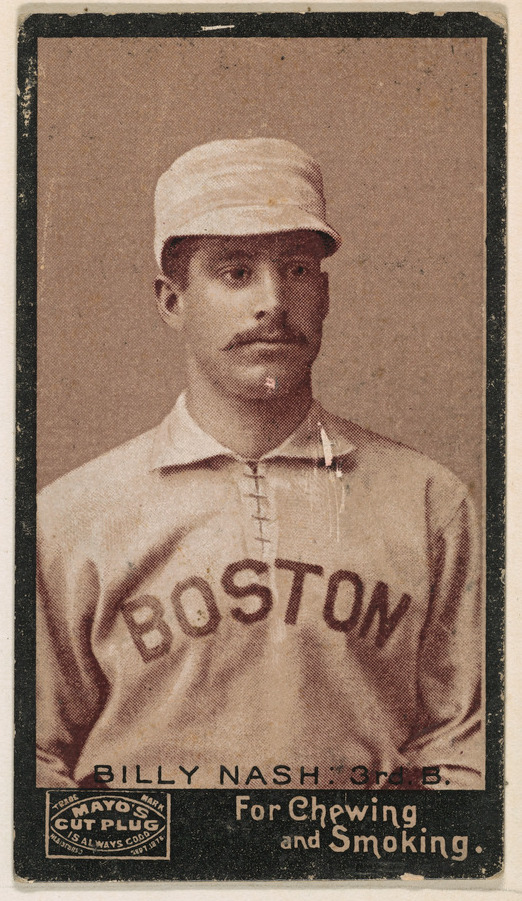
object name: print, baseball card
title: Billy Nash, 3rd Base, Boston, Mayo's Cut Plug Baseball series (N300)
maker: p.h. mayo & brother, richmond, virginia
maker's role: publisher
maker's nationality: american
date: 1895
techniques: lithography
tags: men,portraits,baseball,athletes